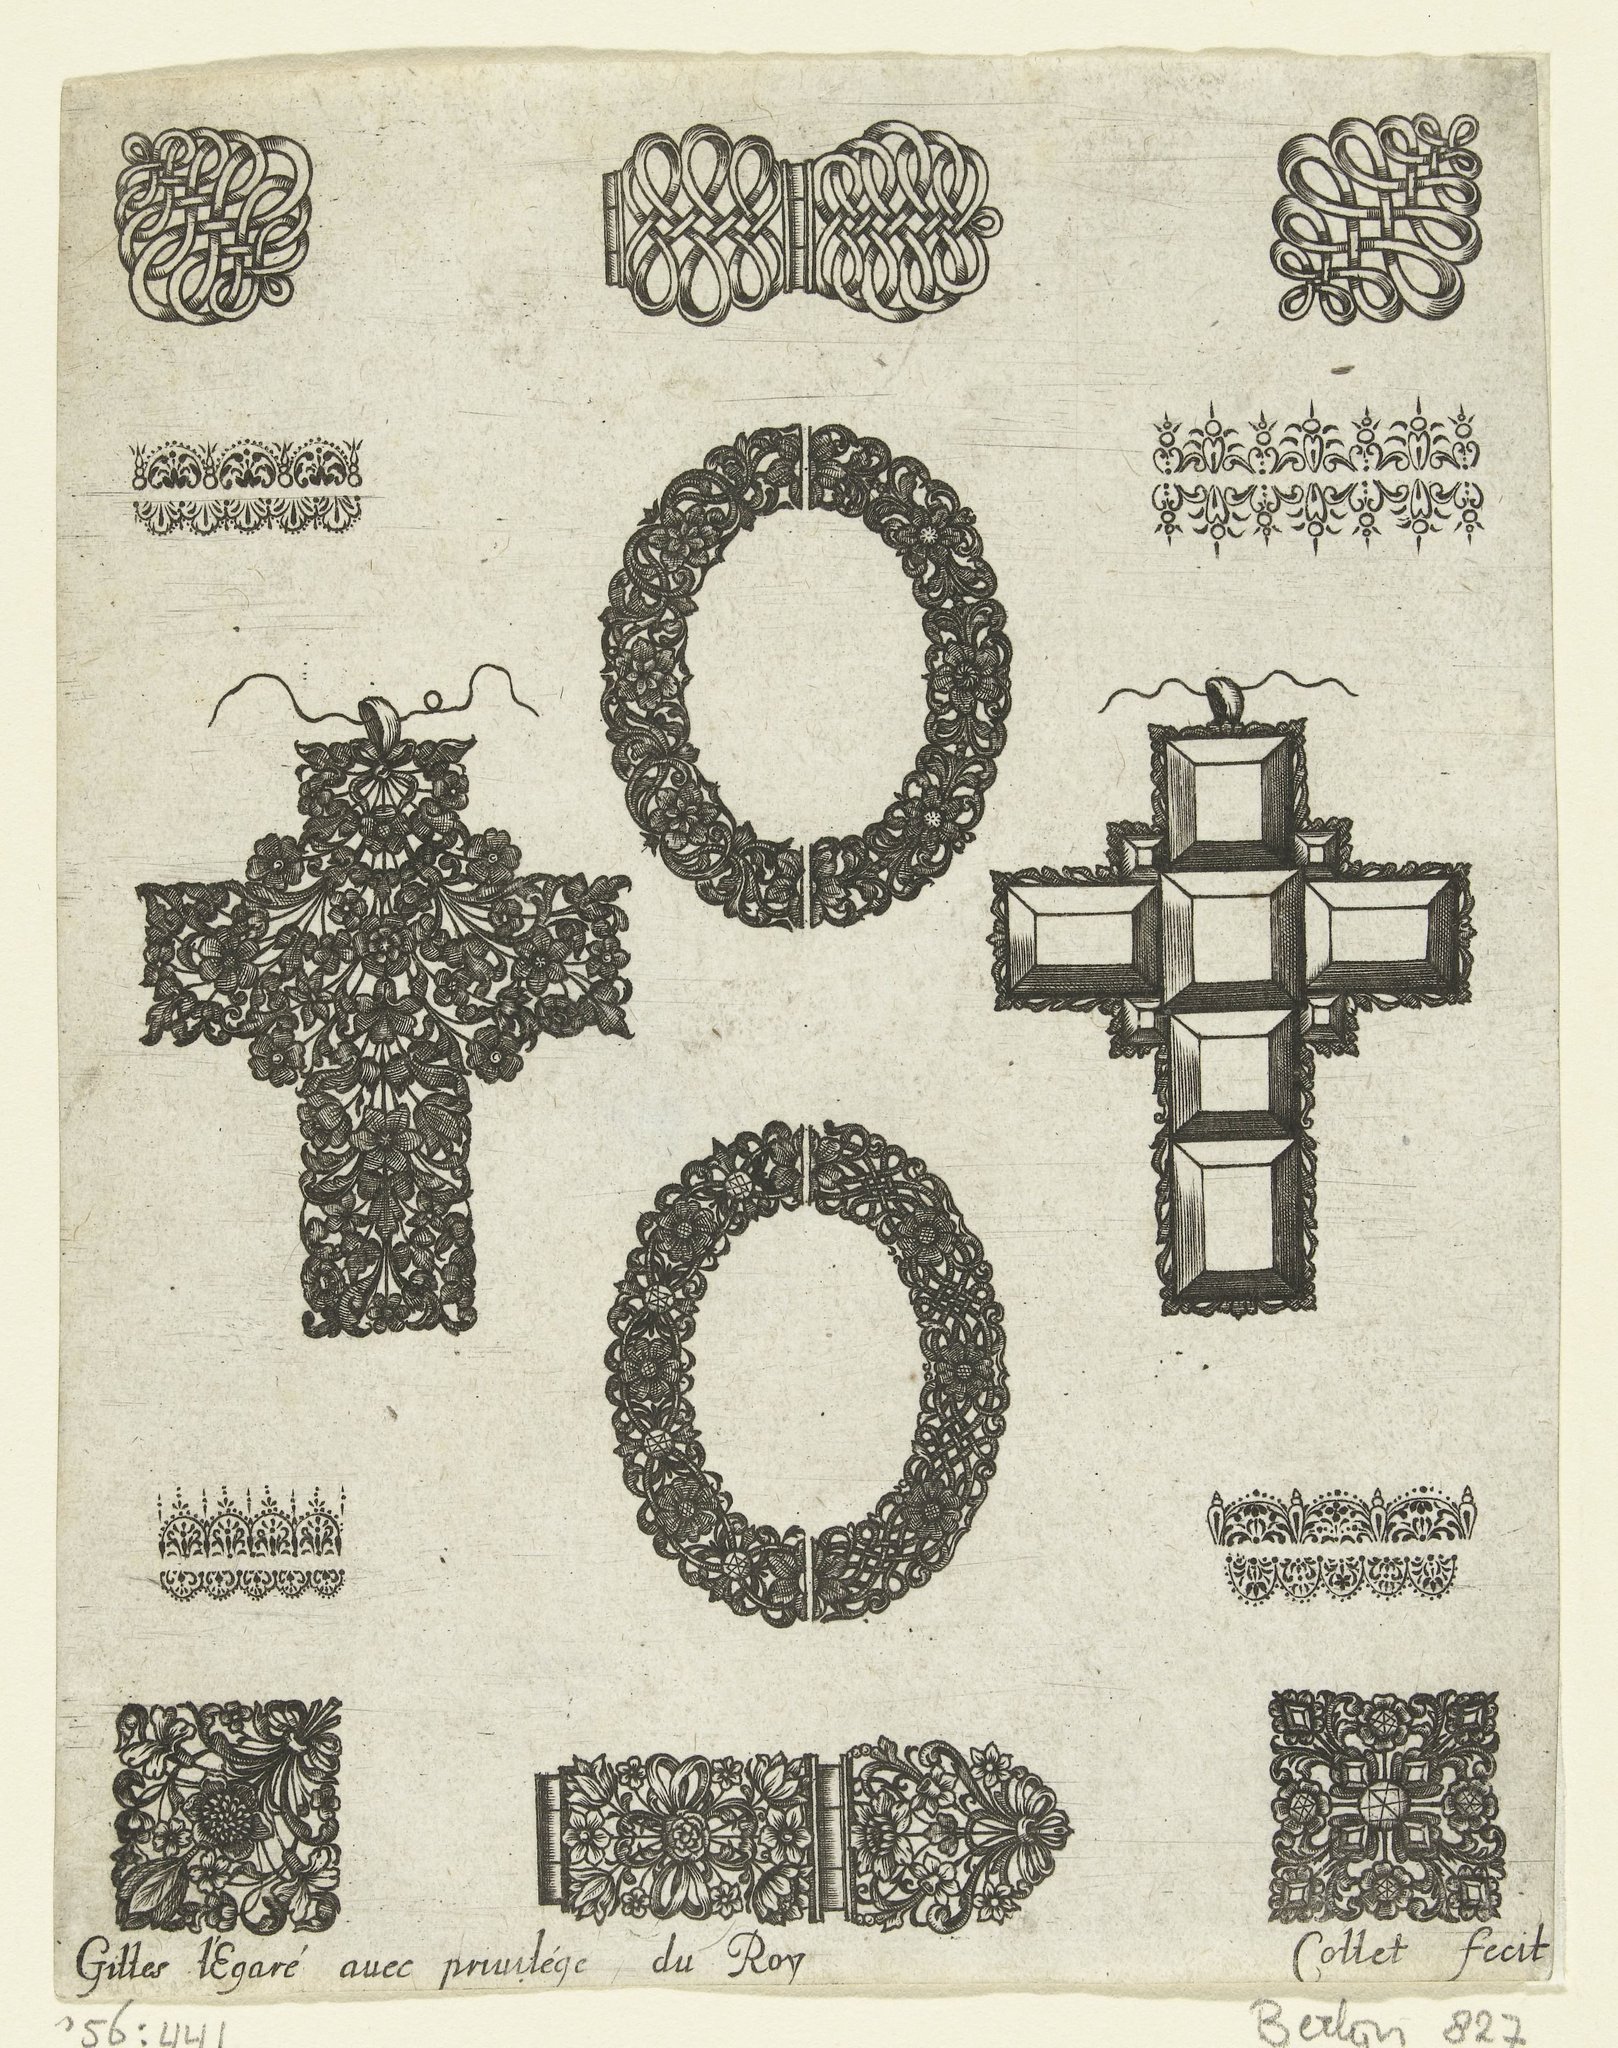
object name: print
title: Livre des Ouvrages d'Orfevrerie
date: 1663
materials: paper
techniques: engraving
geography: paris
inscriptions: collector's mark: Lugt 2228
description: Vier hoekmotieven, twee scharnieren, twee medaillons of randen van cameeën, de voor- en achterkant van een kruis en vier dubbele ornamentele randen. Blad 7 uit serie van 8 bladen met ontwerpen voor juwelen.